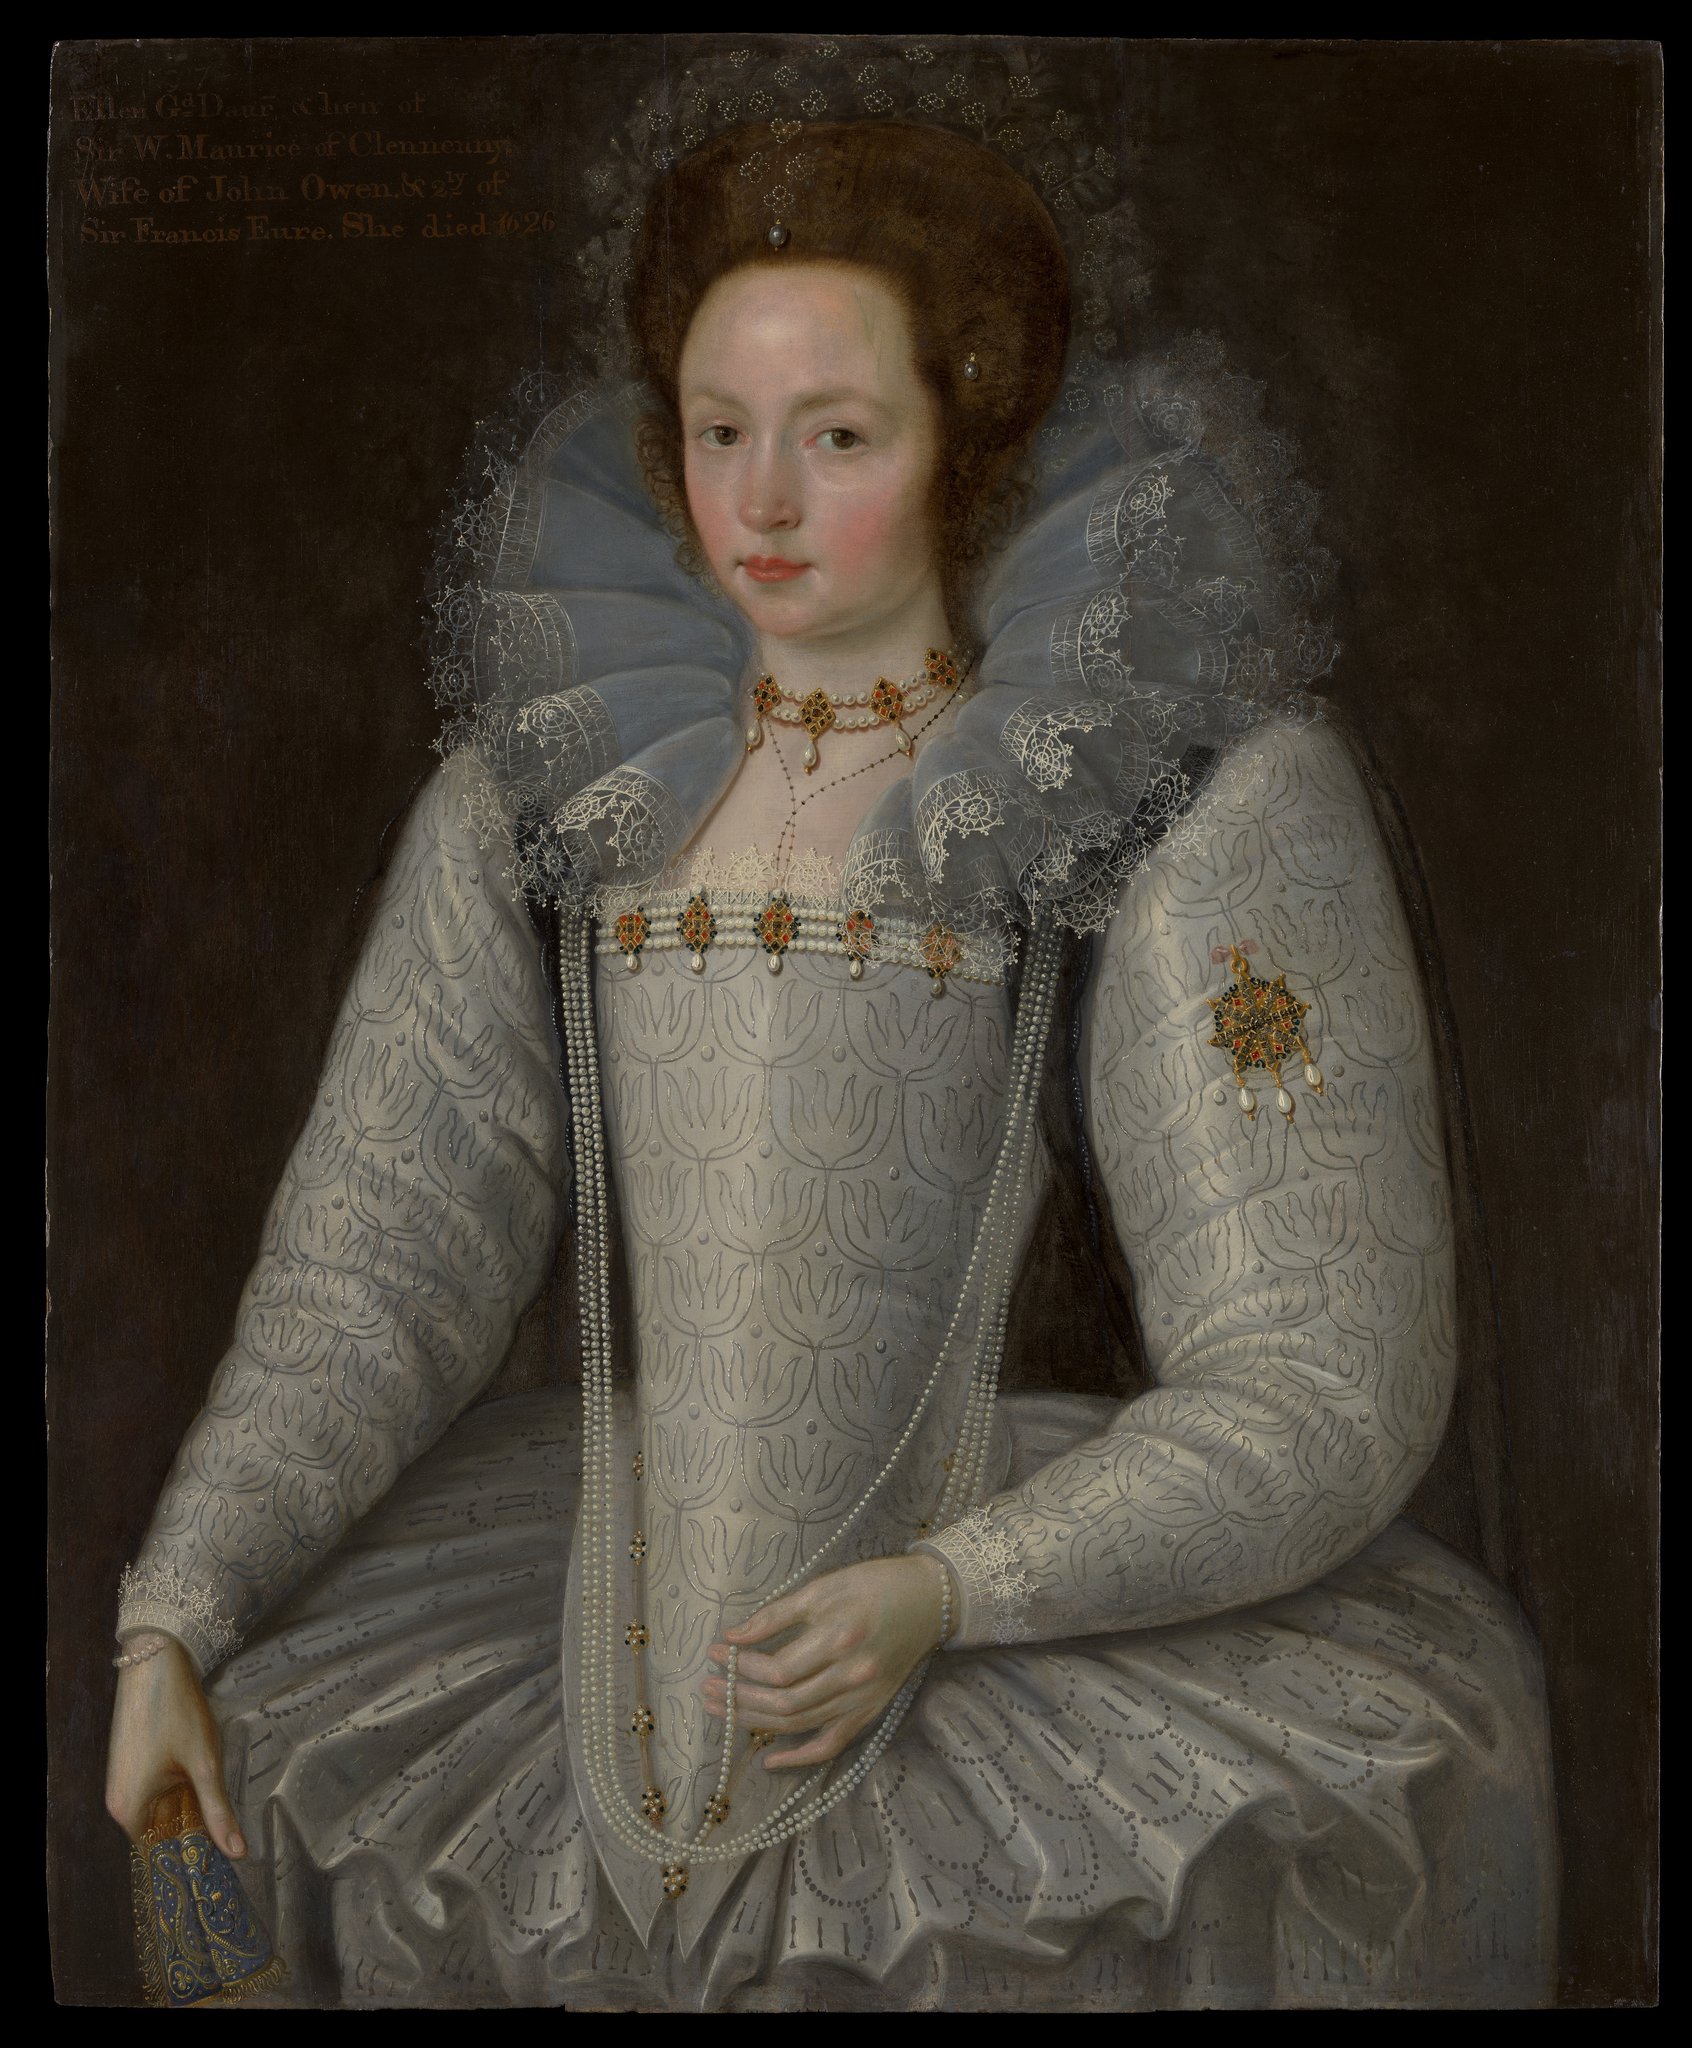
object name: painting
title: Ellen Maurice (1578–1626)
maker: marcus gheeraerts the younger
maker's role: artist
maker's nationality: flemish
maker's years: 1561-1635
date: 1597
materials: wood, oil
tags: portraits,women